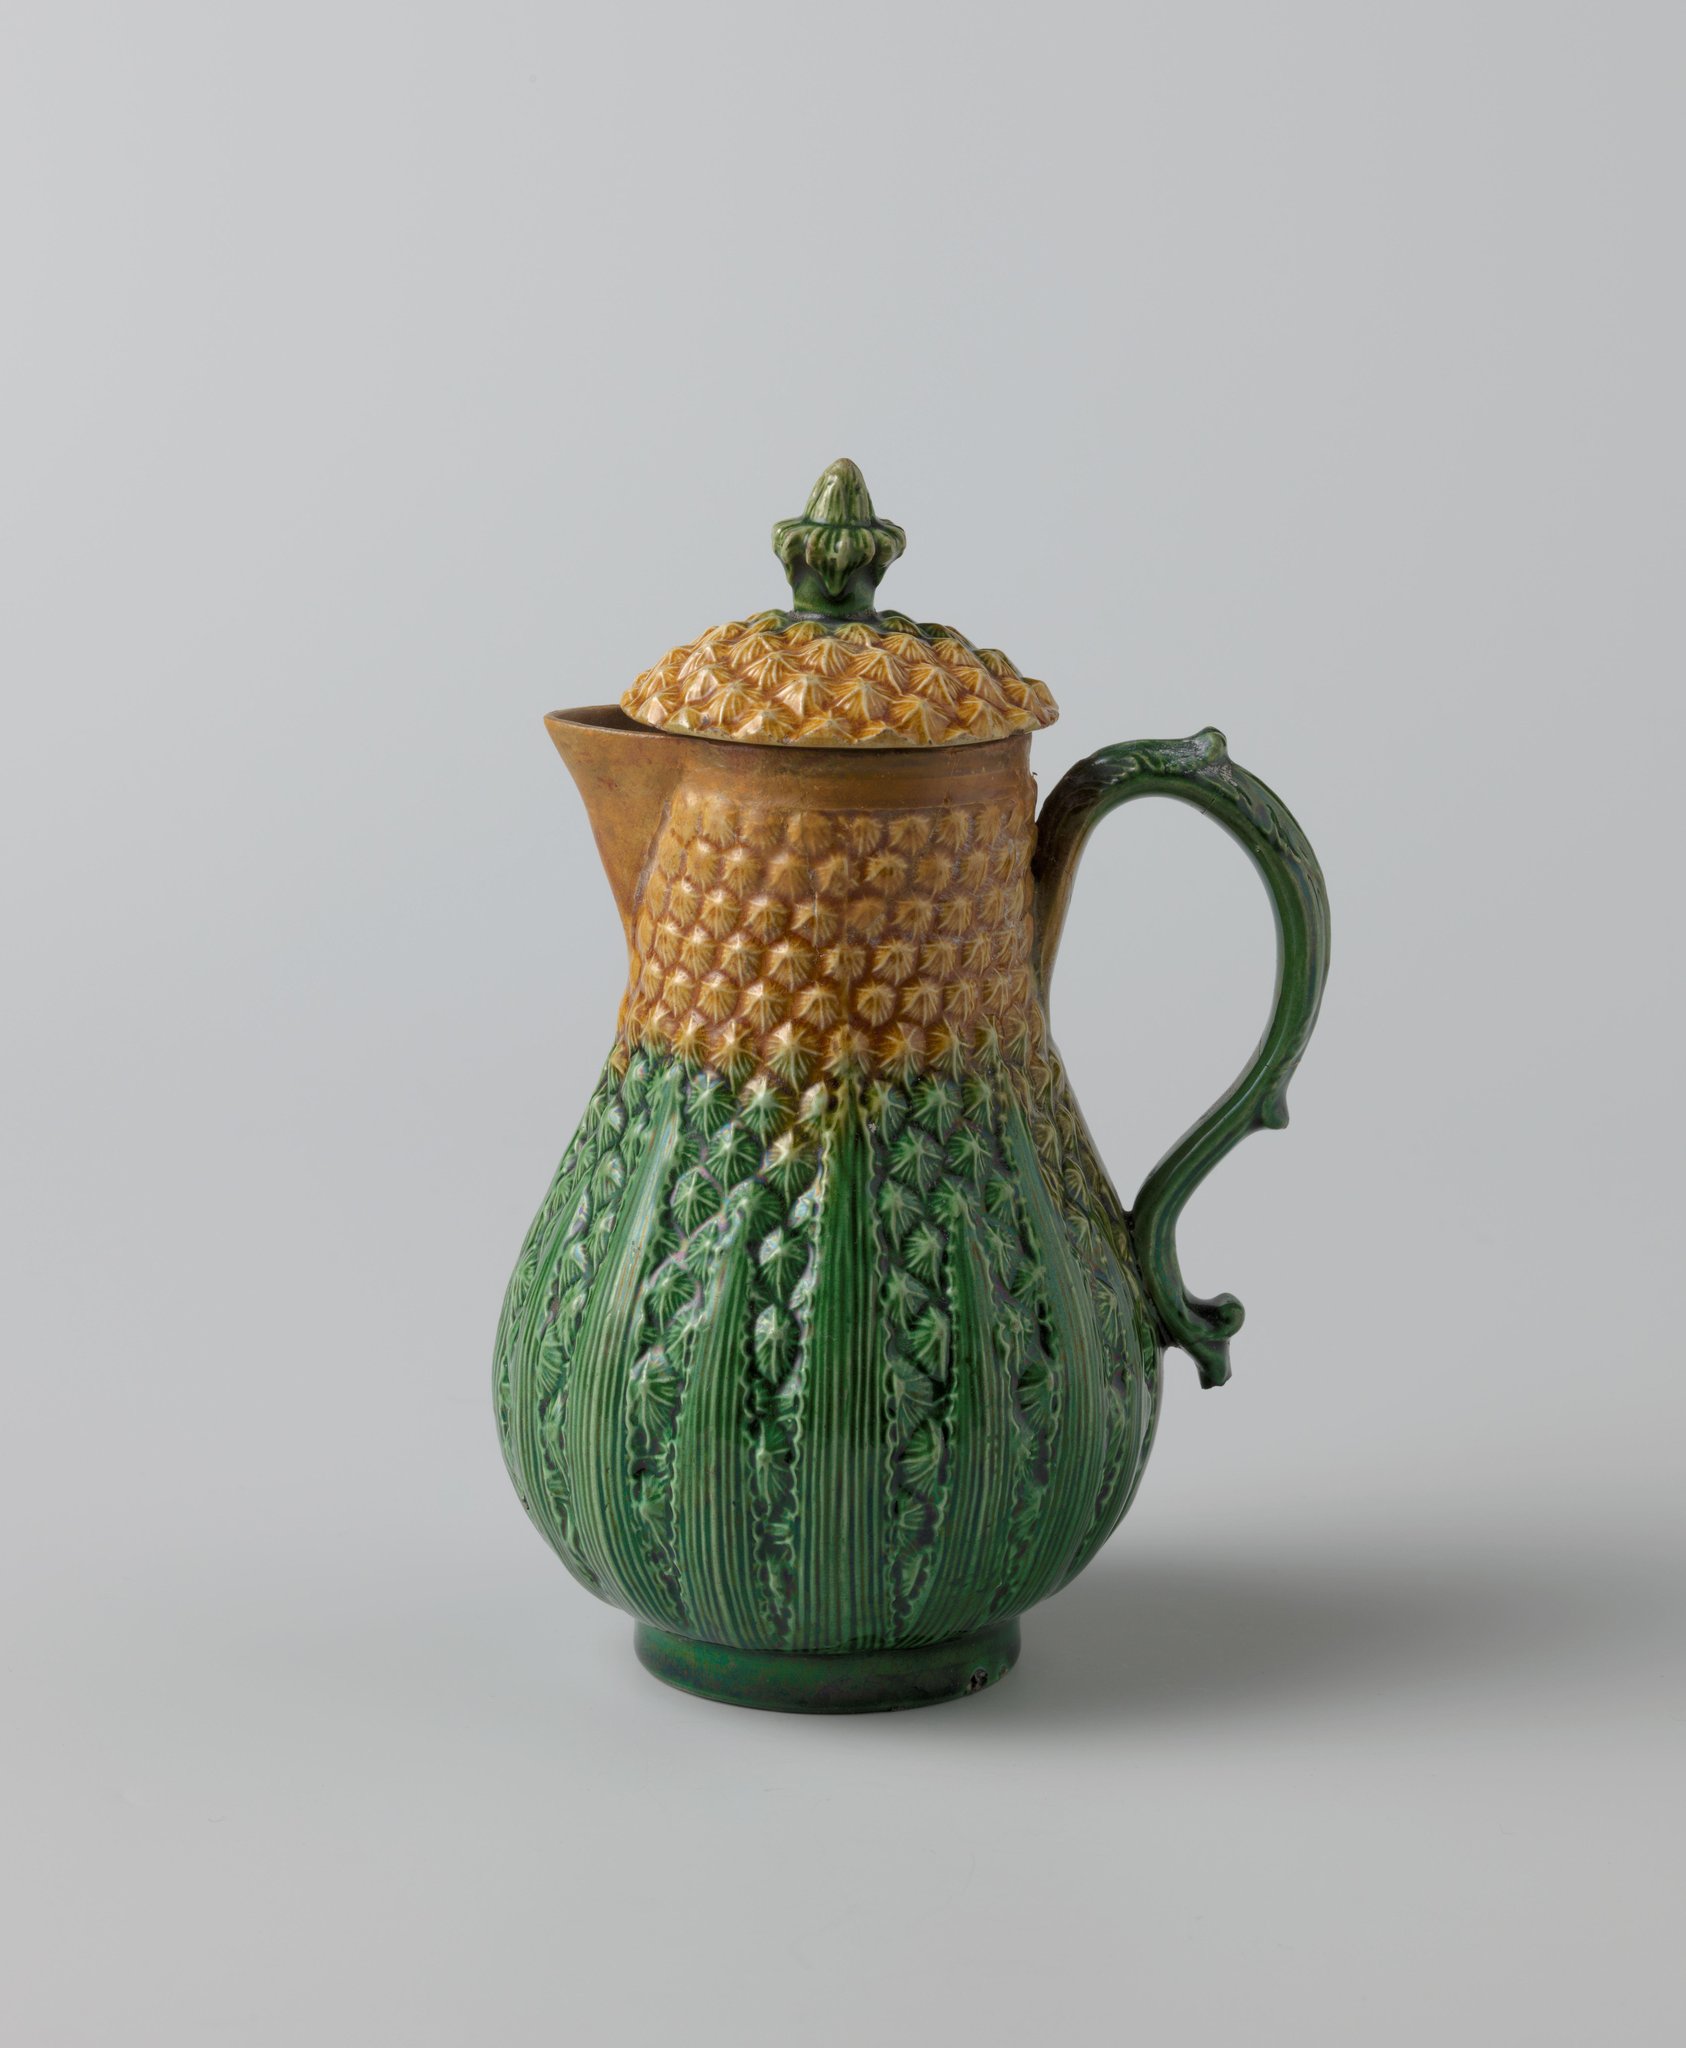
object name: ewer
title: Deksel van hardgebakken aardewerk; Whieldon ware, pineapple ware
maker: Anonymous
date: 1765-1775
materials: earthenware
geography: england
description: Deksel van hardgebakken aardewerk met bloemvormige knop.